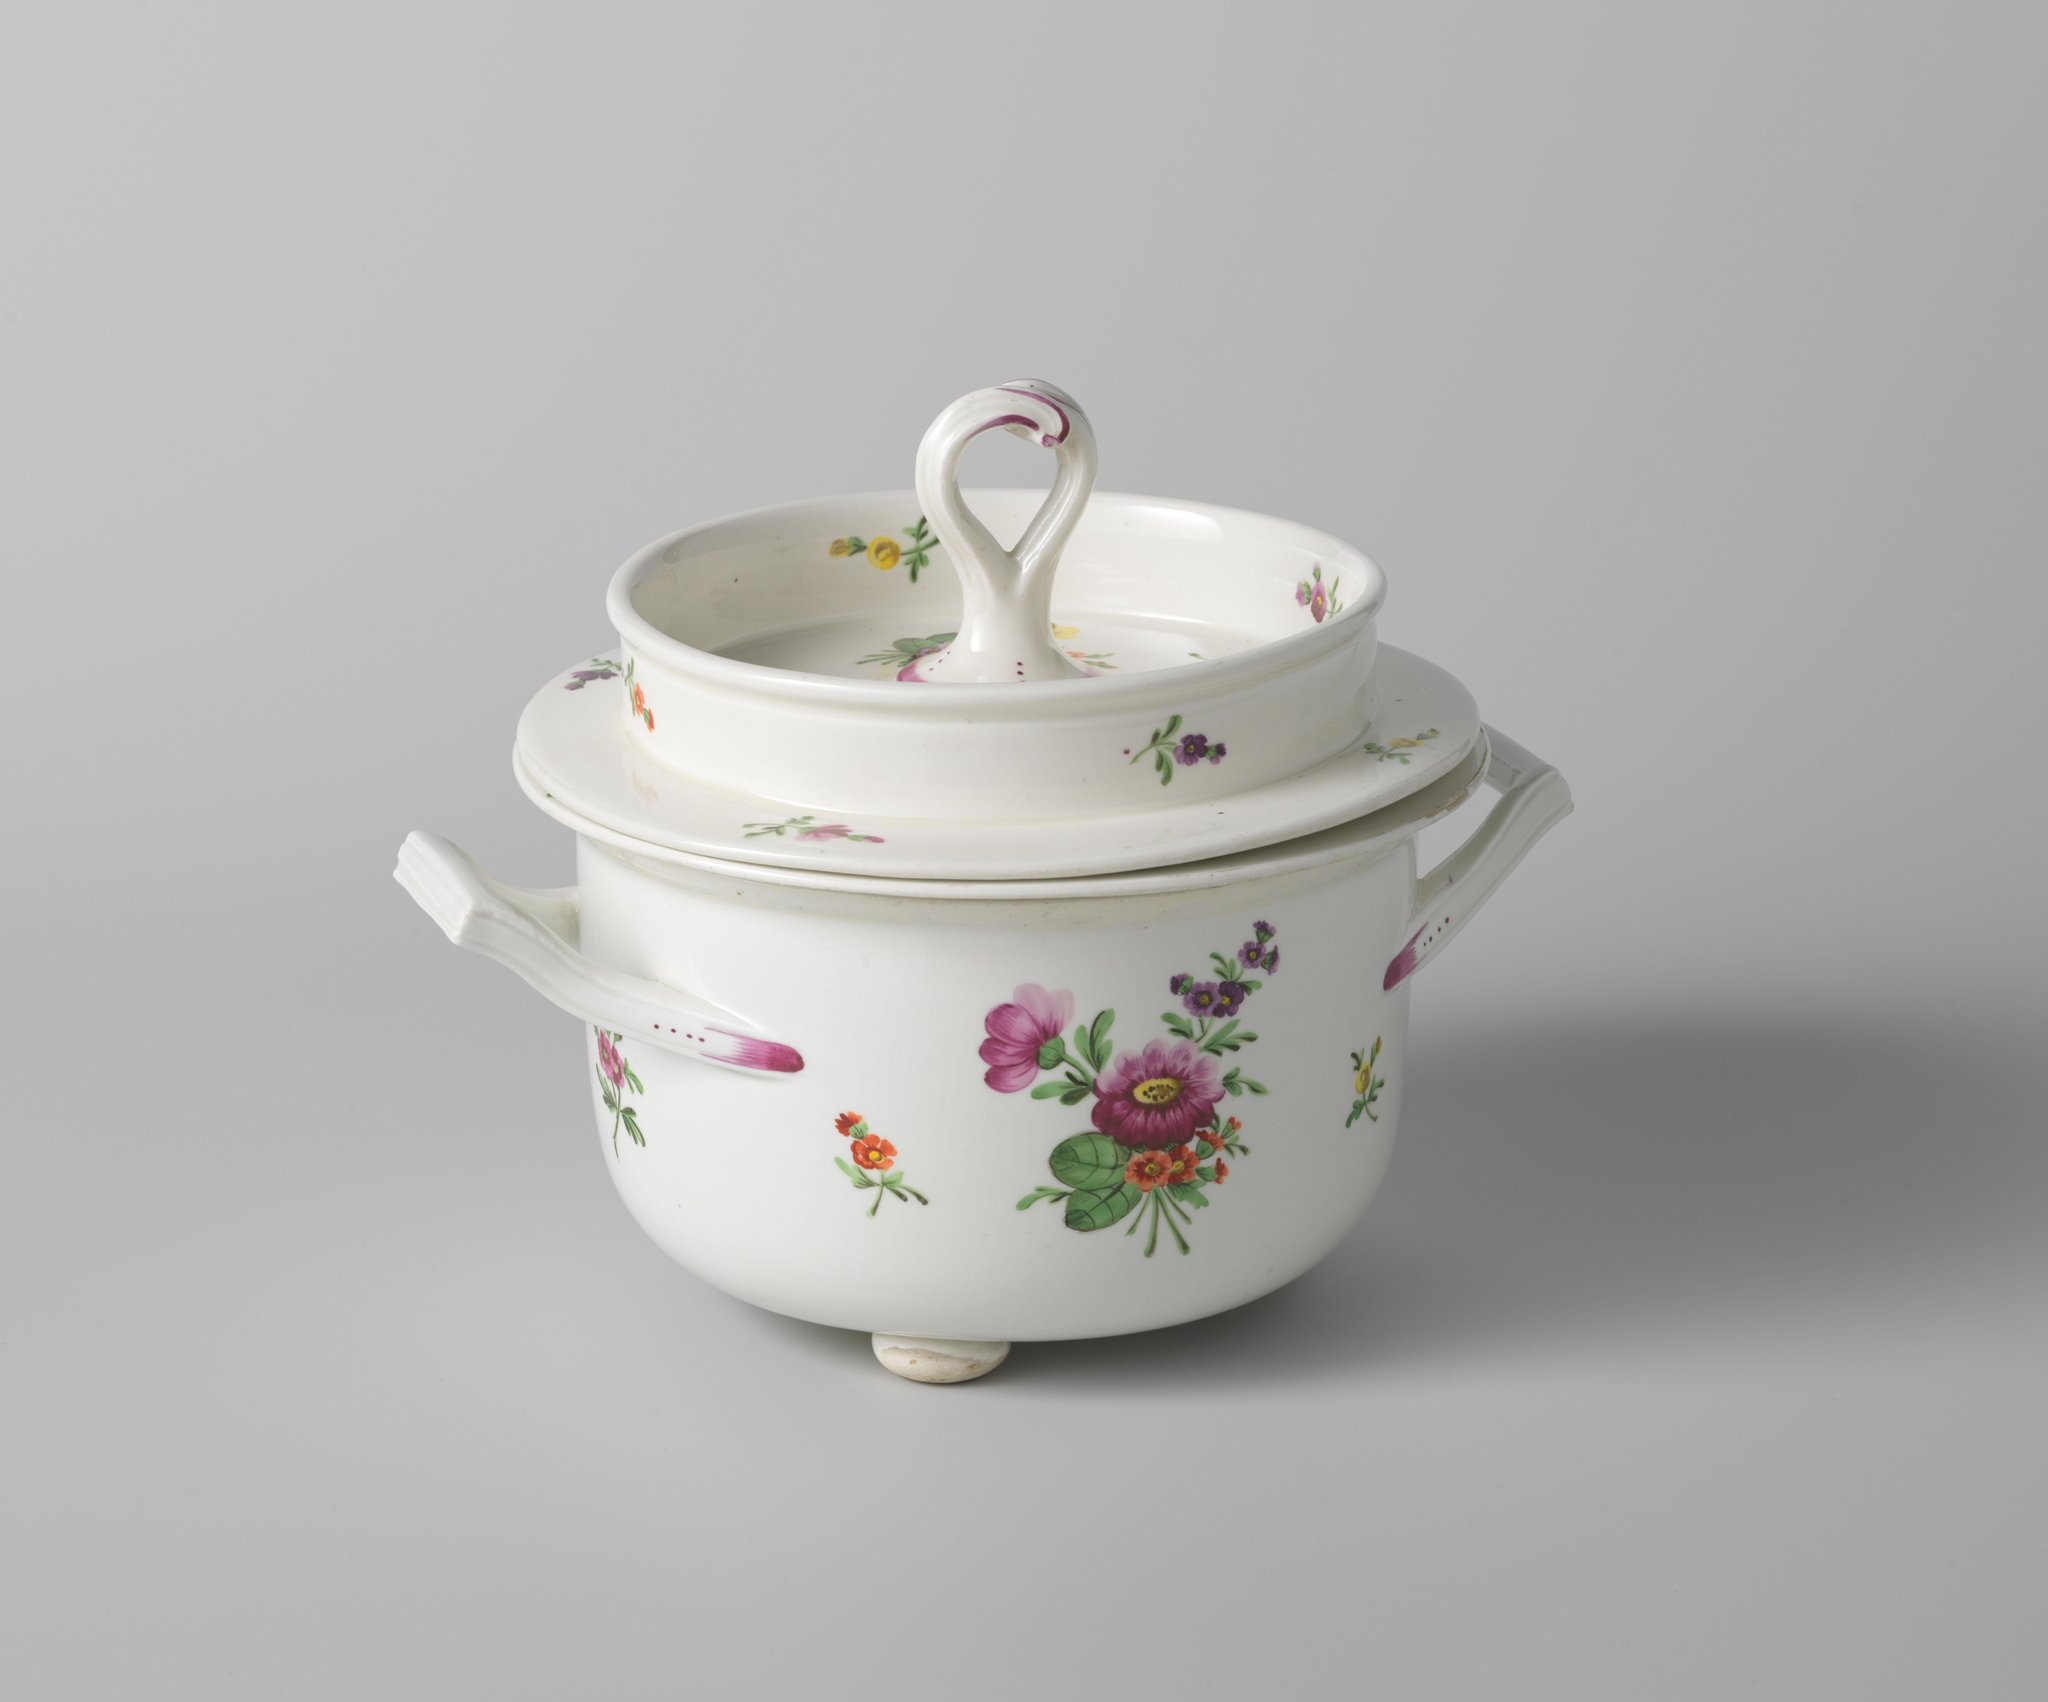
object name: service set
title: Rechaud with bouquets and flower sprays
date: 1800-1849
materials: glaze, paint, porcelain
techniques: firing, forming, turning, vitrification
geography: vienna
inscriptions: mark: ‘schild’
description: Réchaud, onderdeel van een servies, beschilderd met veelkleurige bloemboeketten en strooibloemen; bestaande uit drie delen, rond met rechte oren en staande op drie ronde voetjes. Gemerkt: P85 in paars en ingegrift de letter L. In onderglazuur blauw een wapenschild met twee dwarsbalken.